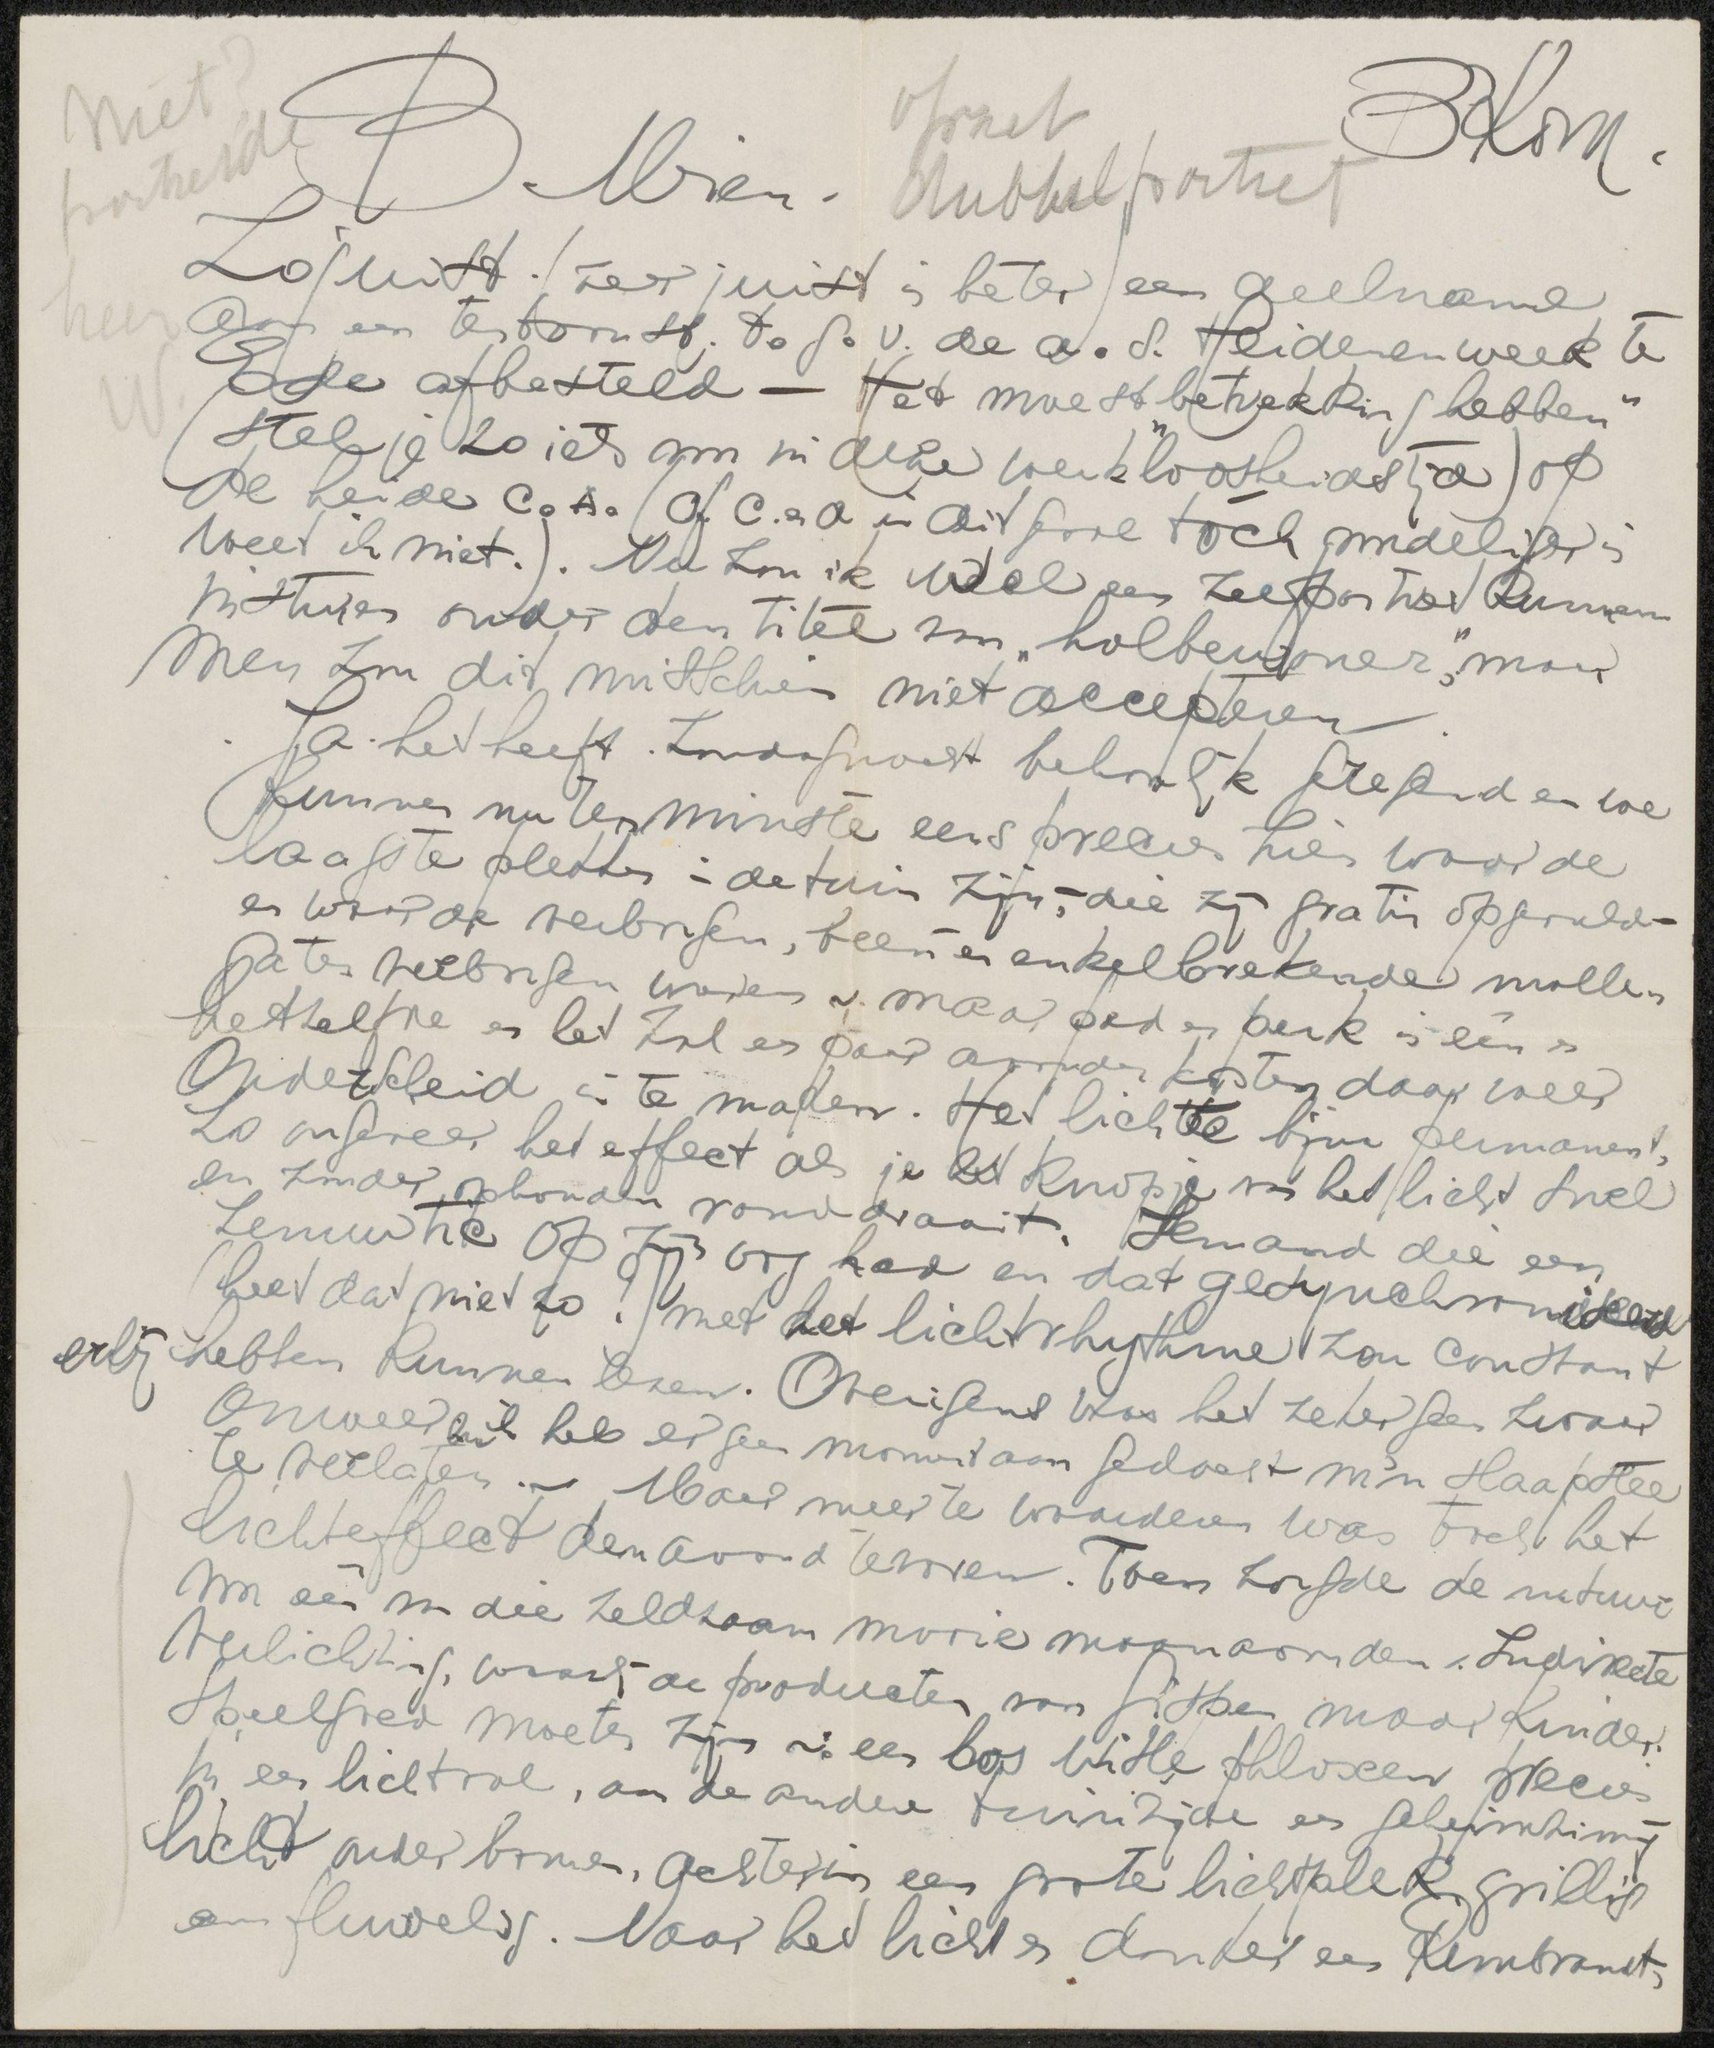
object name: letter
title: Brief aan Mien Cambier van Nooten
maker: dick ket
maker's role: draughtsman, print maker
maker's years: 1902-1940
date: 1912-1940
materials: ink, paper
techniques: pen, writing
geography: bennekom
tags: arnhem, print maker, draughtsman, mien cambier van nooten, artist's model, sitter, drawing, exhibition ~ art, historical persons (portraits and scenes from the life)